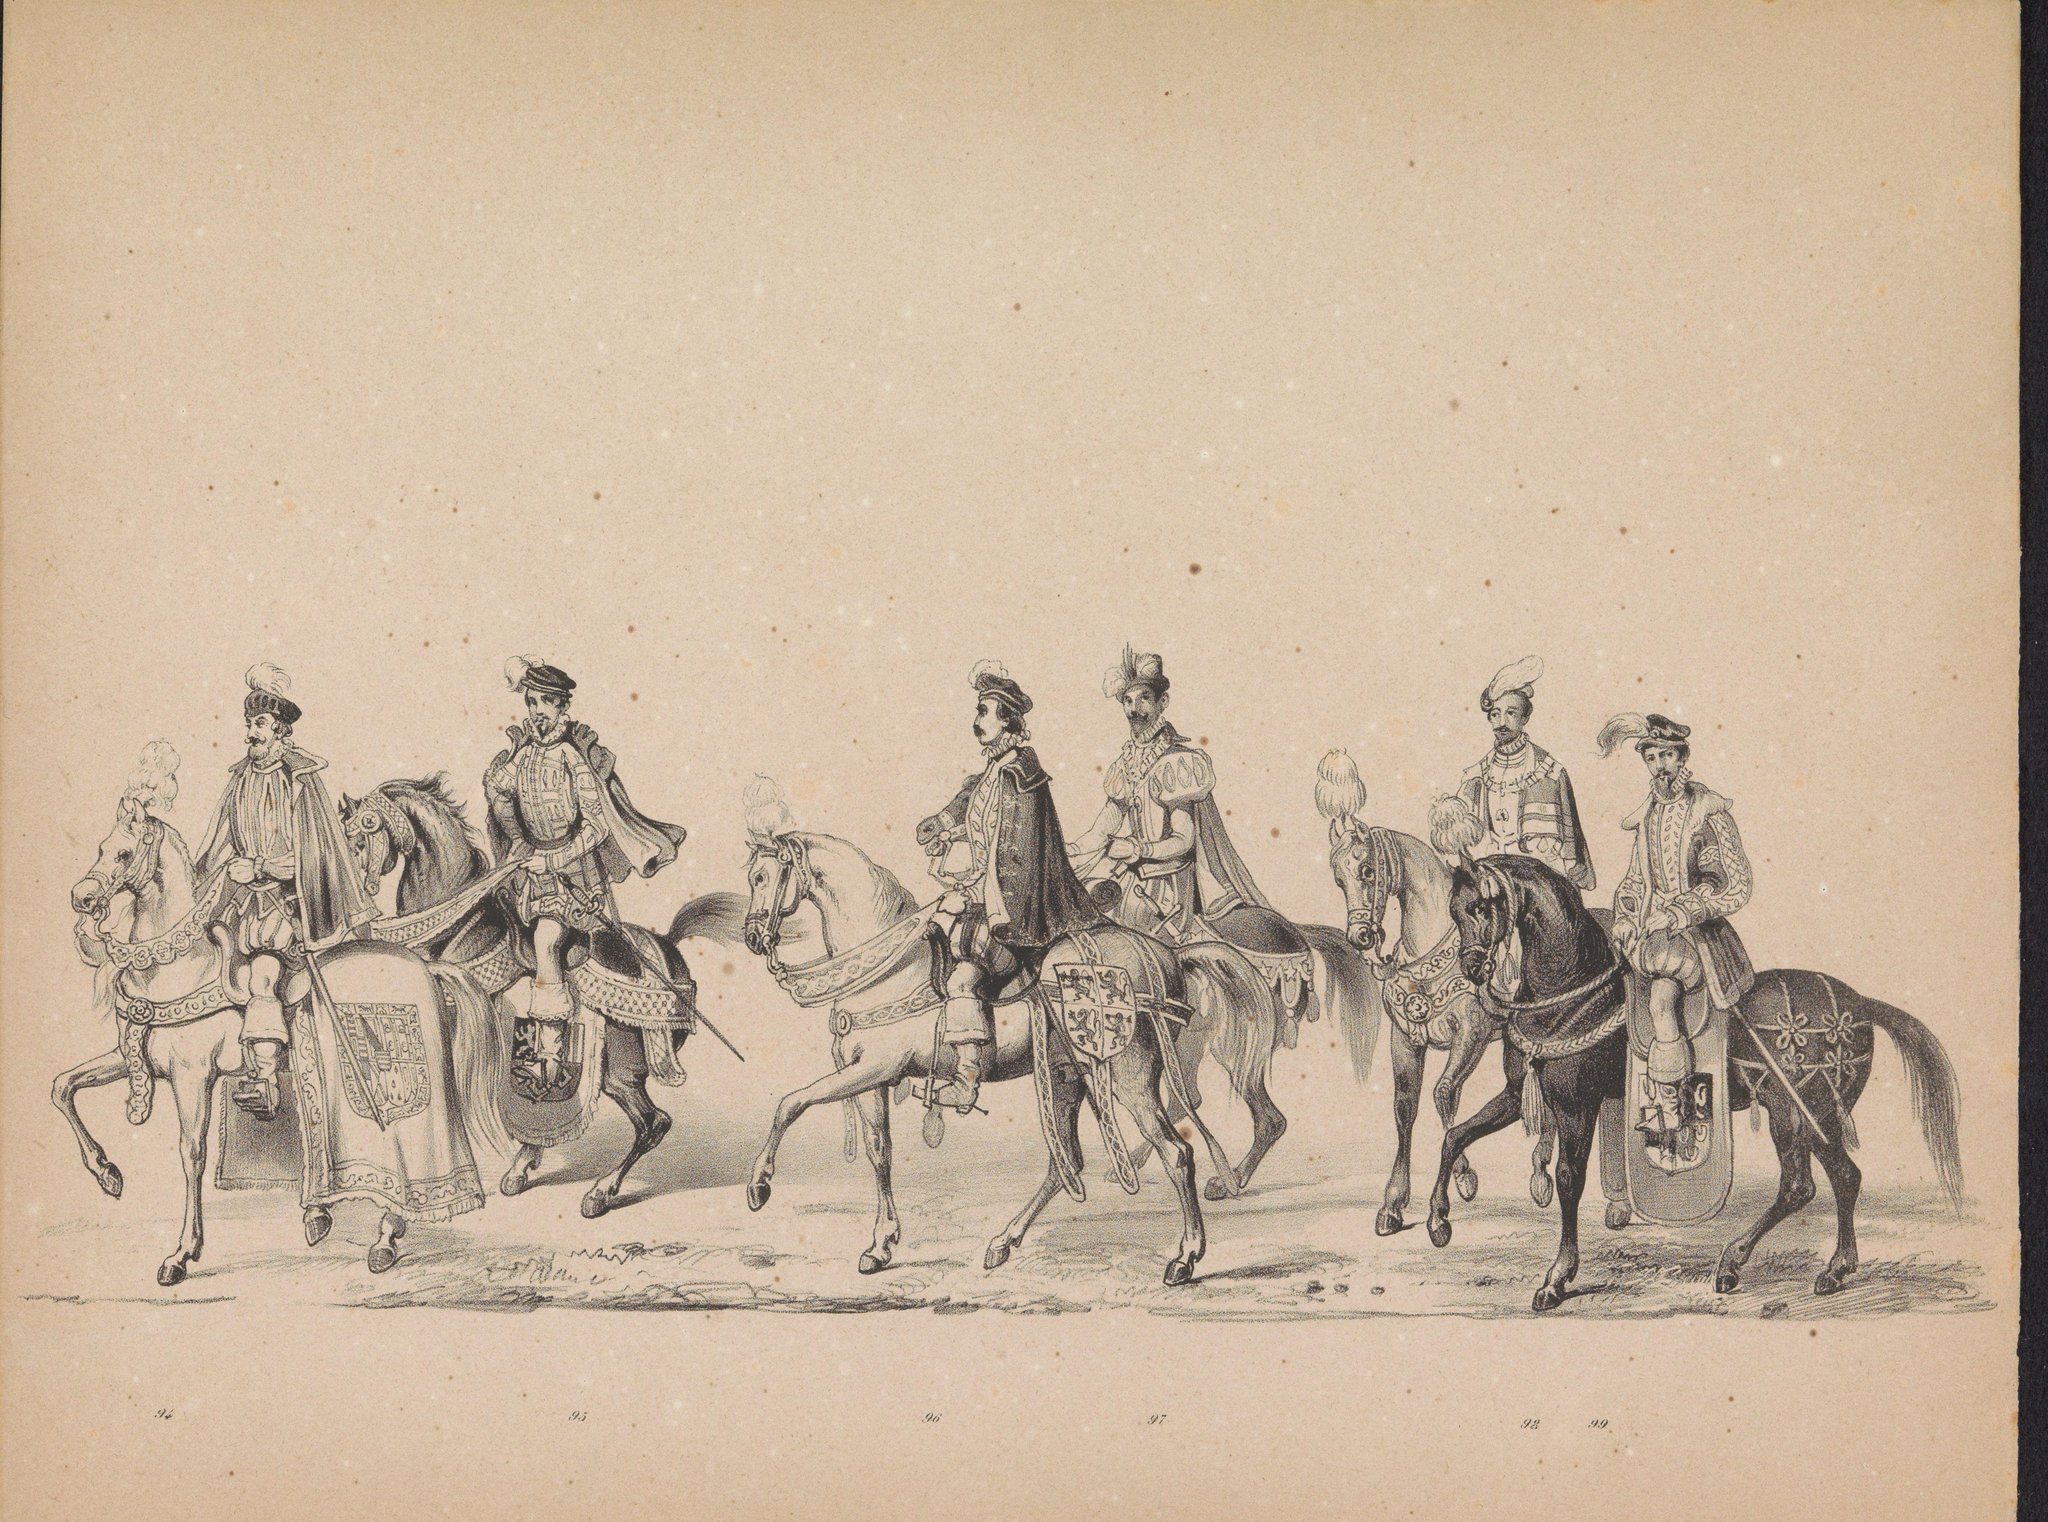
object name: print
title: Afbeelding van den gecostumeerden optogt, voorstellende den in togt van Philips II, Prins van Spanje, in Utrecht, den 3en October 1549, gehouden den 17en Junij 1846, door H.H. Studenten der Utrechtsche Hoogeschool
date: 1847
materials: paper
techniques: lithograph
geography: leiden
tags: philip ii of spain, students' pageant, costumes used in pageants, utrecht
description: Historische gekostumeerde optocht van de studenten van de Utrechtse Hogeschool gehouden op 17 juni 1846 ter gelegenheid van het 210-jarig bestaan van de Hogeschool. De optocht verbeeldt de intocht van Filips II in Utrecht op 3 oktober 1549. Plaat met de groepen genummerd 94-99. Onderdeel van de serie van 22 aanelkaar te plakken losse bladen.